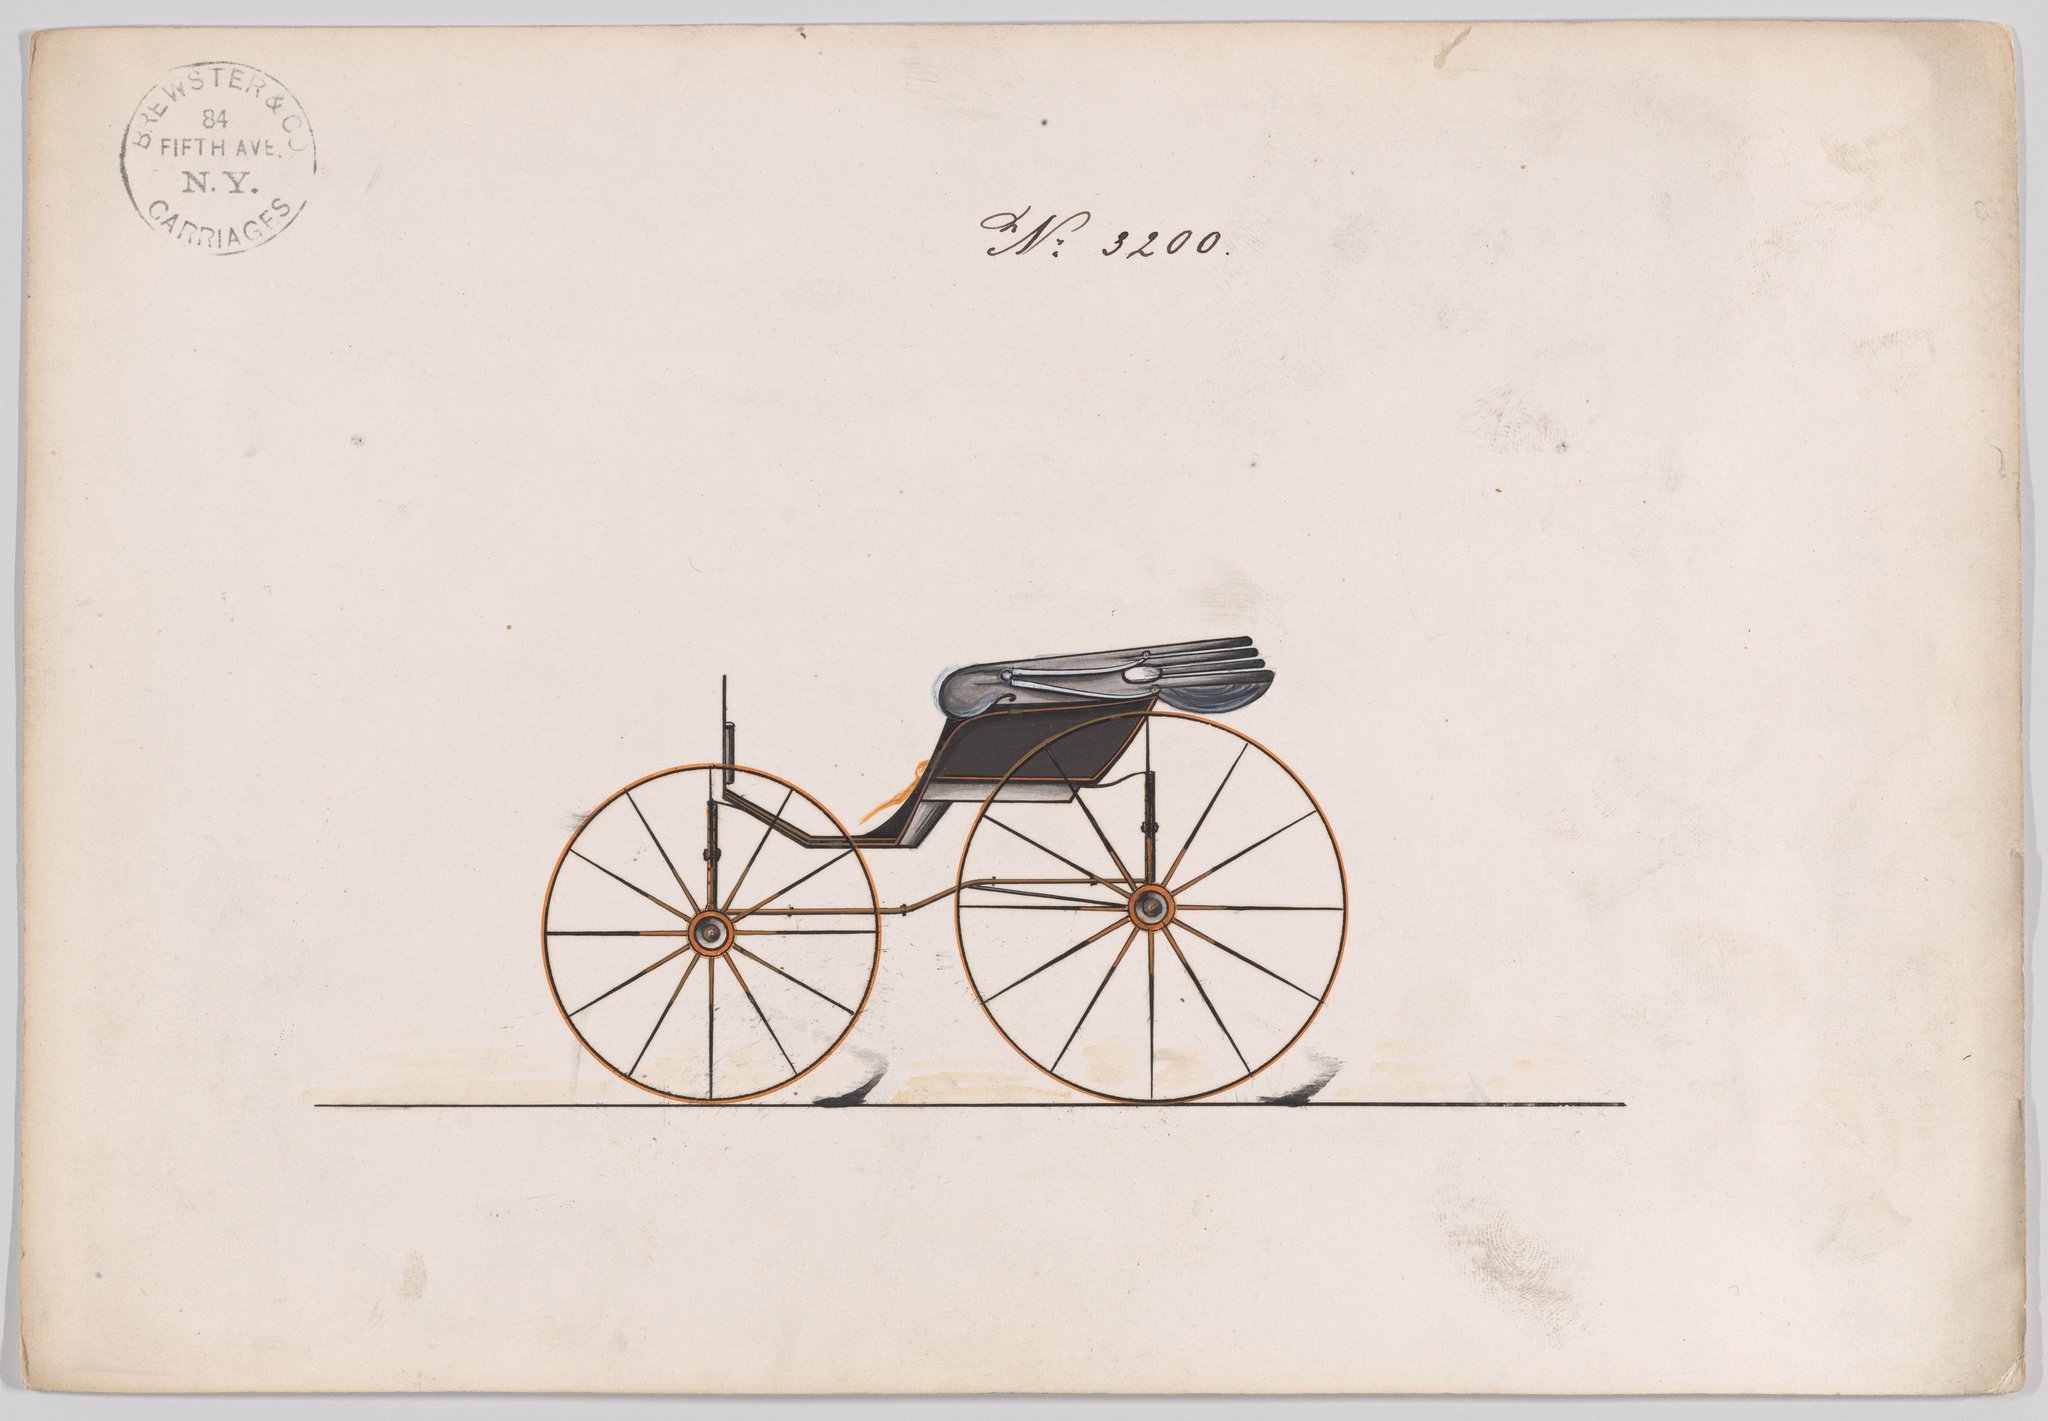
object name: drawing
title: Design for Pony Phaeton, no. 3200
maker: brewster & co.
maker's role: manufacturer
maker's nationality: american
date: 1876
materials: gouache, ink, watercolor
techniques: pen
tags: carriages